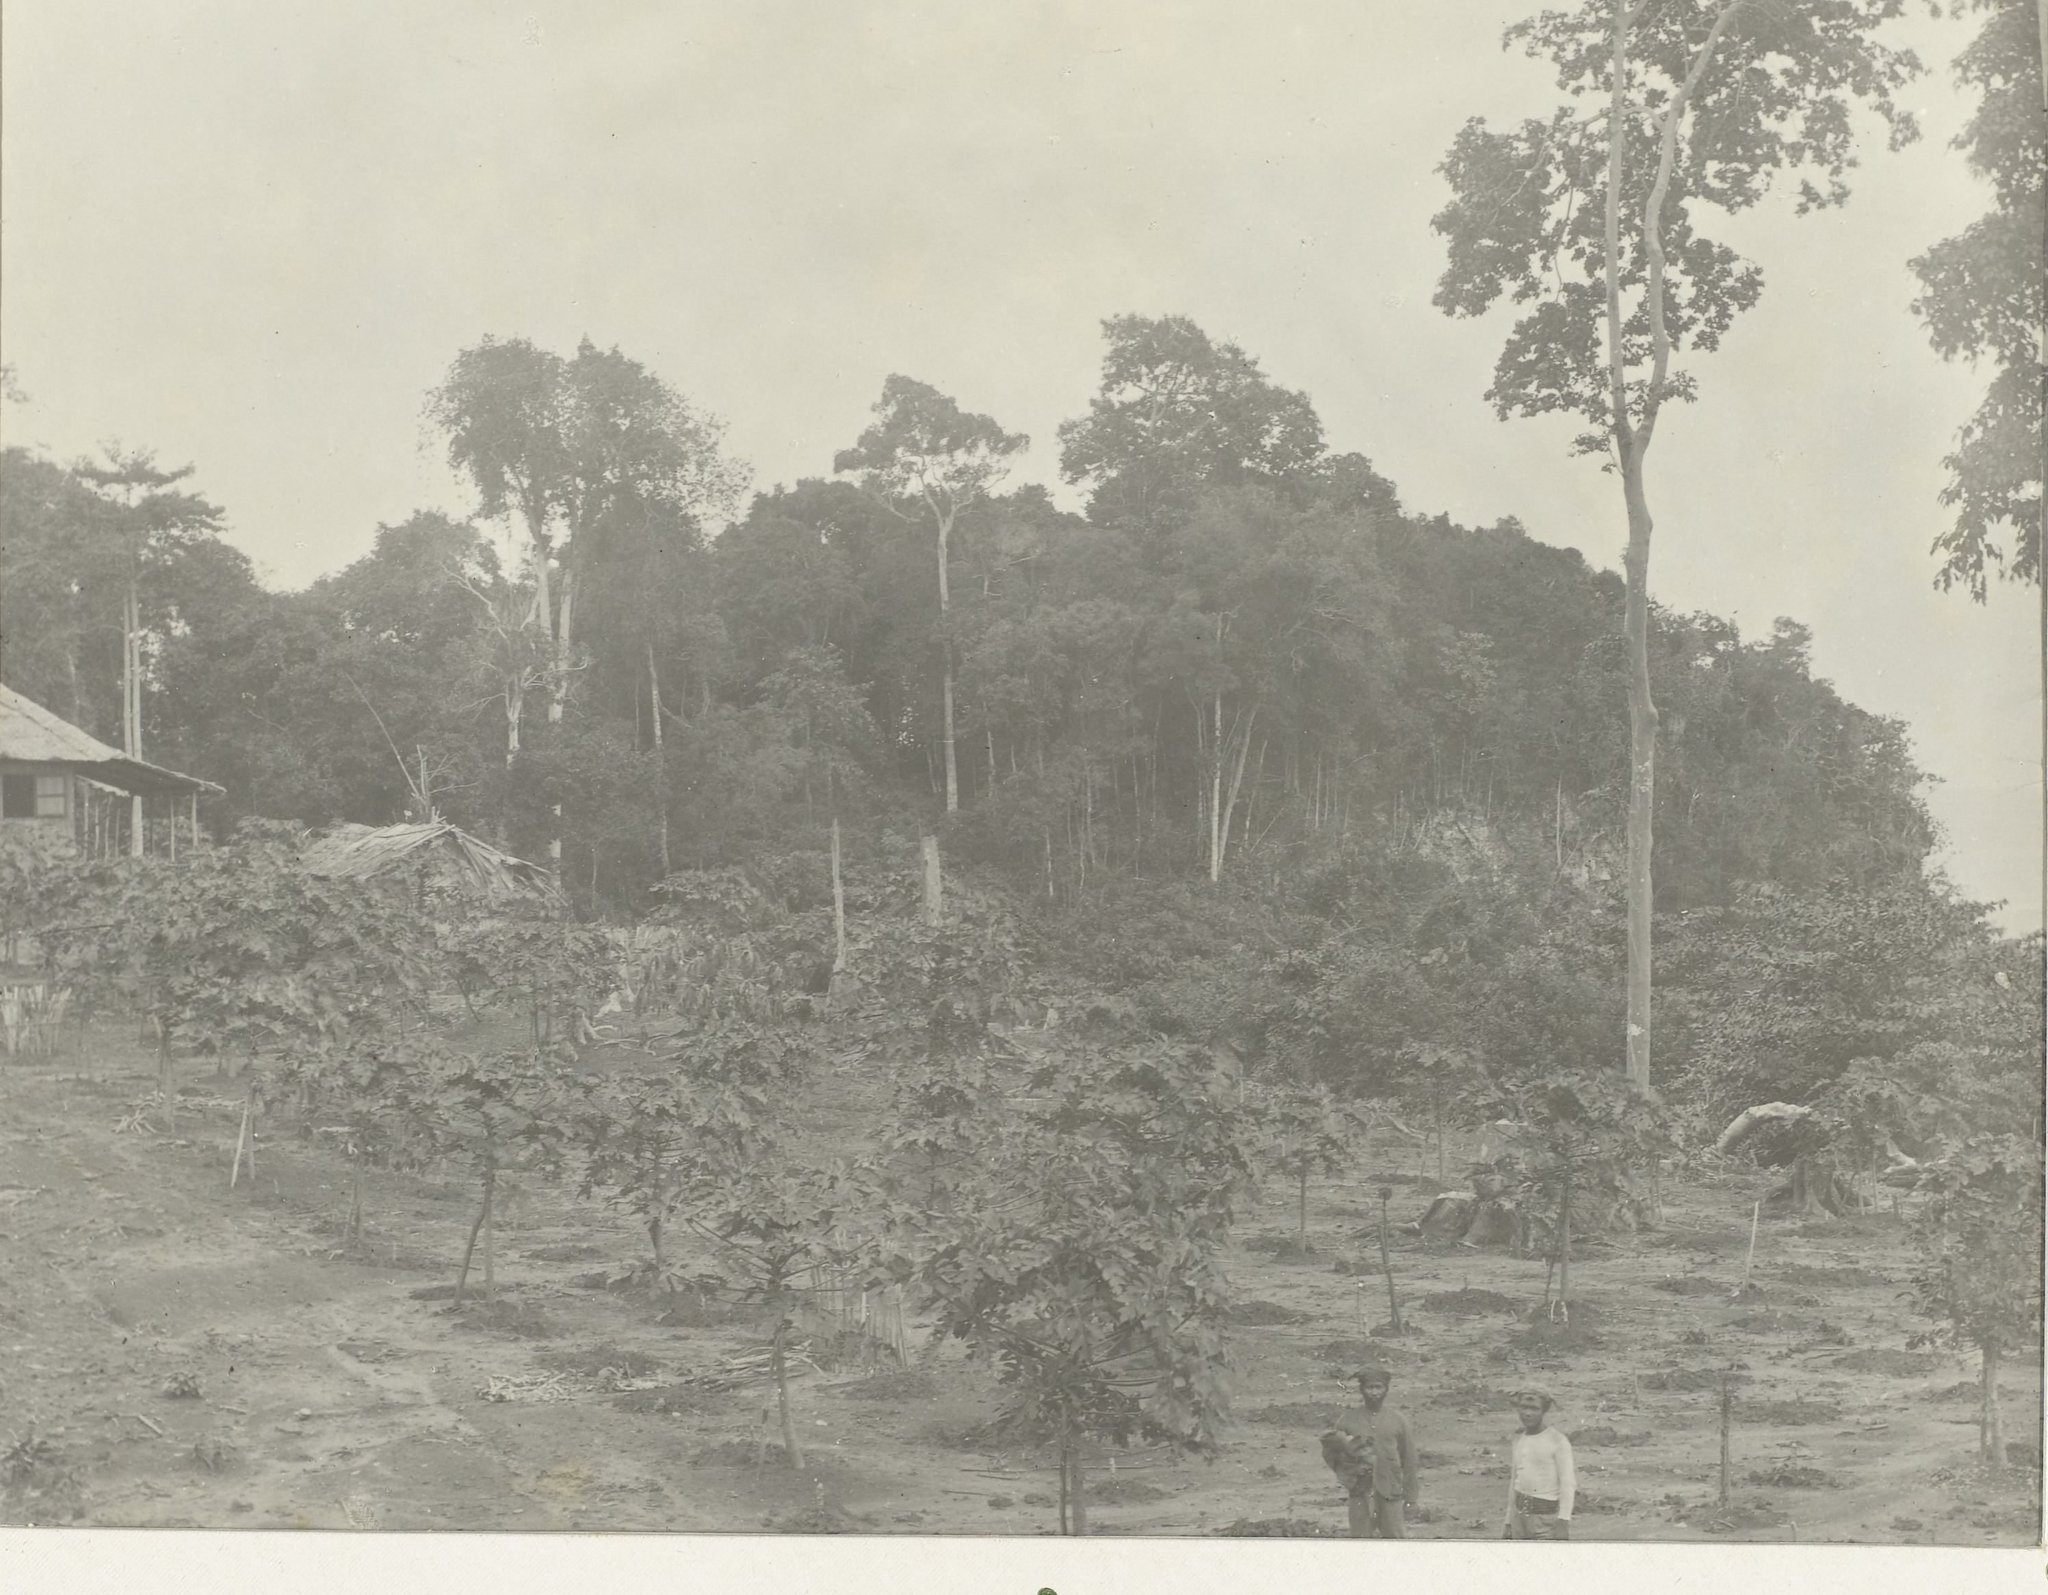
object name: photograph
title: Plantage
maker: Anonymous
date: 1903-1907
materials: paper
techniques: gelatin silver print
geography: kalimantan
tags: plantation, borneo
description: Een kleine plantage met bomen op een helling, op de voorgrond twee leden van de lokale bevolking. Foto in het fotoalbum over de oliewinning op Borneo door de Koninklijke Nederlandsche Petroleum Maatschappij (KNPM) in de jaren 1903-1907.